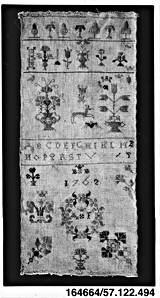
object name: sampler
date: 1762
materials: linen, silk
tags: animals,flowers